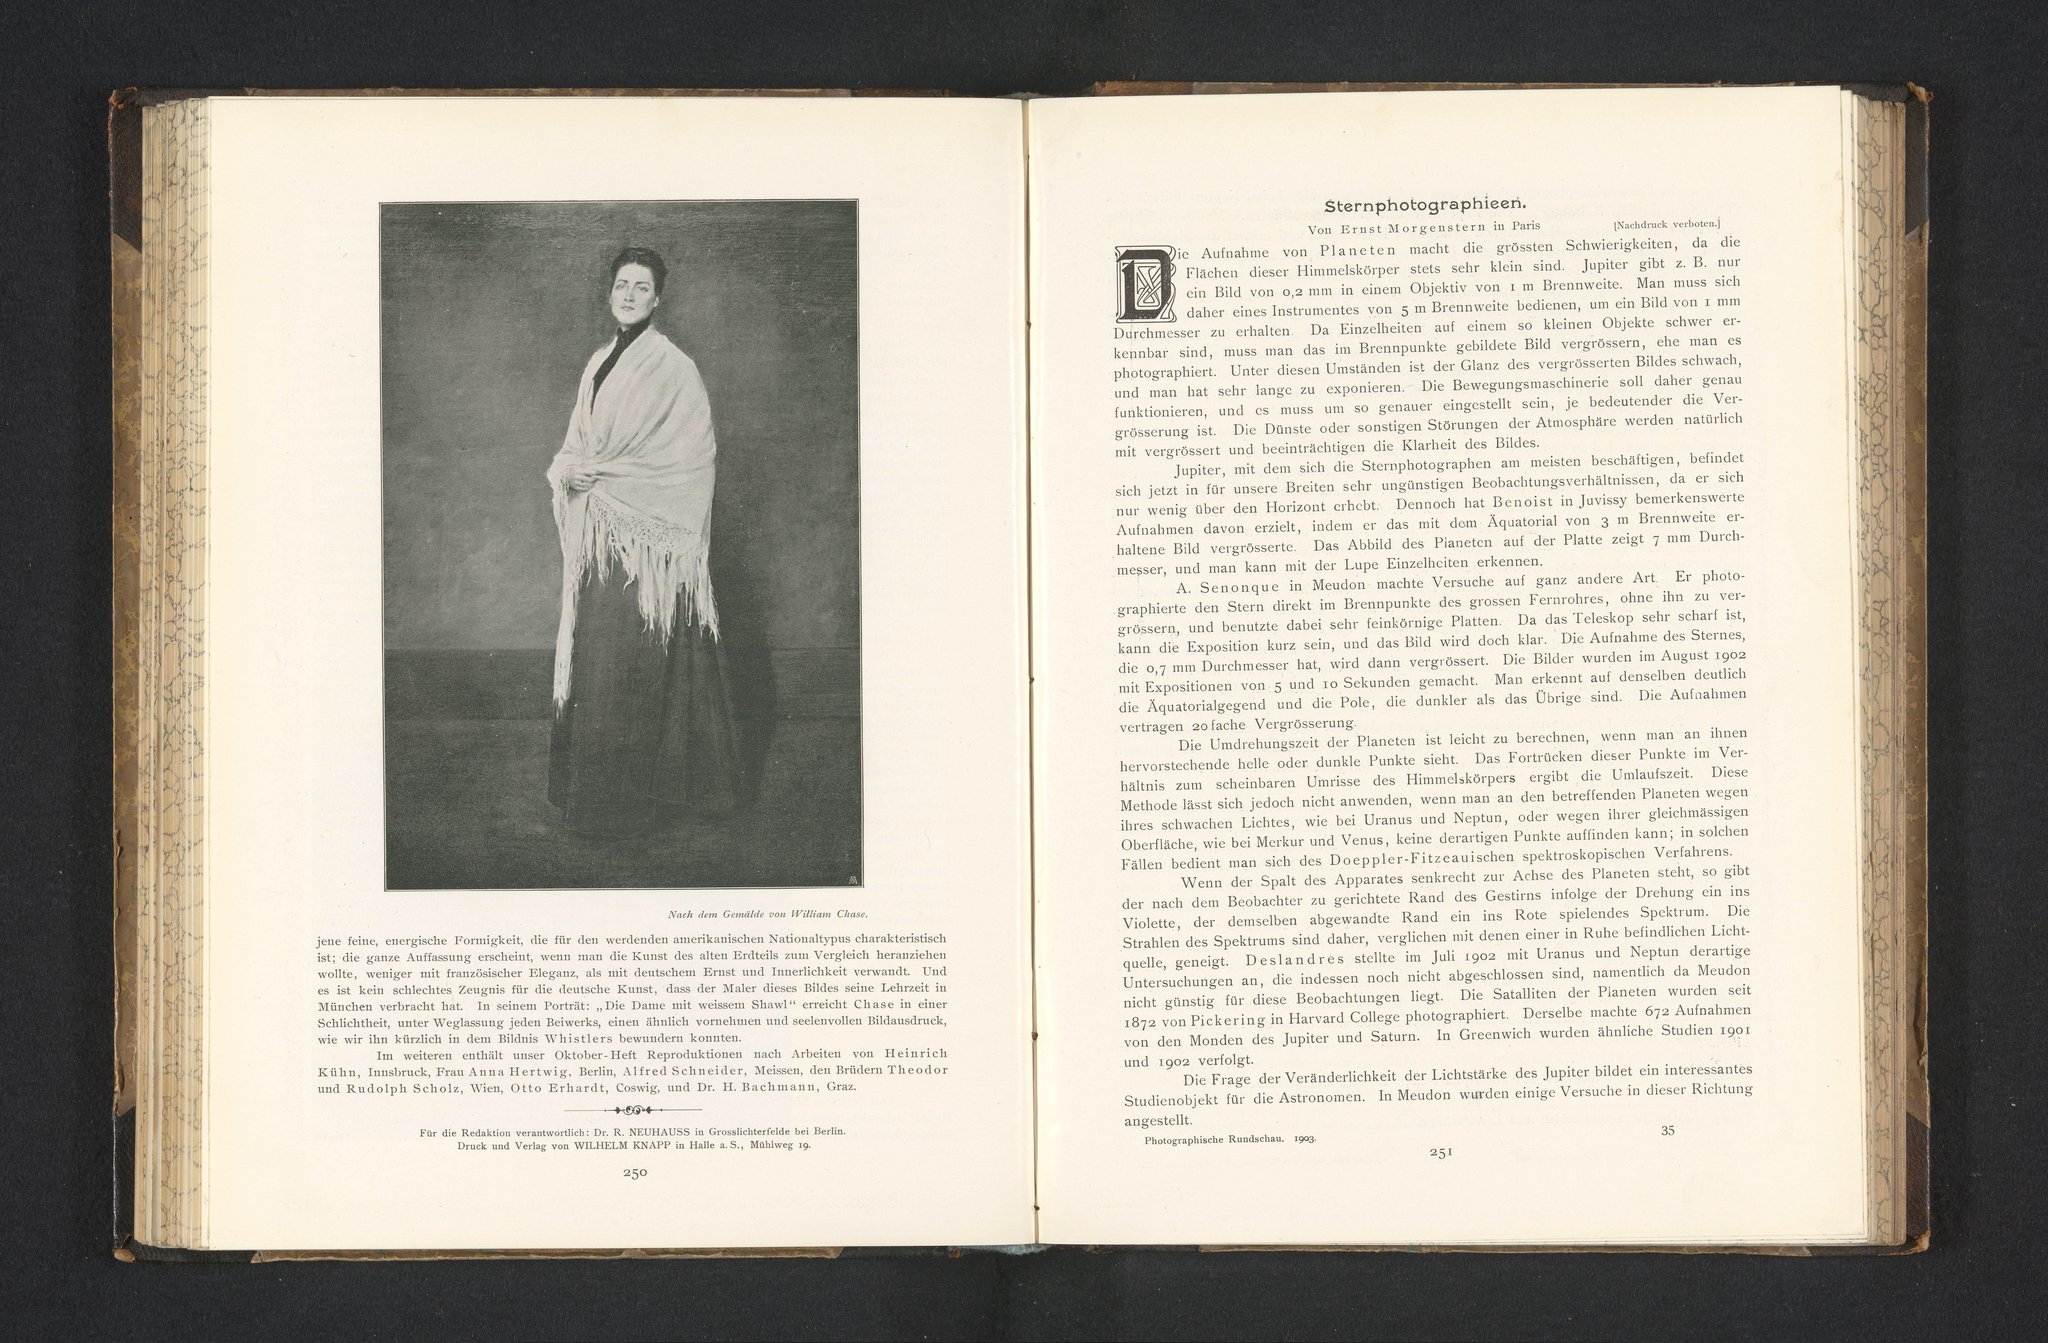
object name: page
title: Reproductie van Portrait of Mrs. C door William Chase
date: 1898-1903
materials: paper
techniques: autotype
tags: historical persons not known by name - bb - woman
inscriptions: monogram: ‘AG’